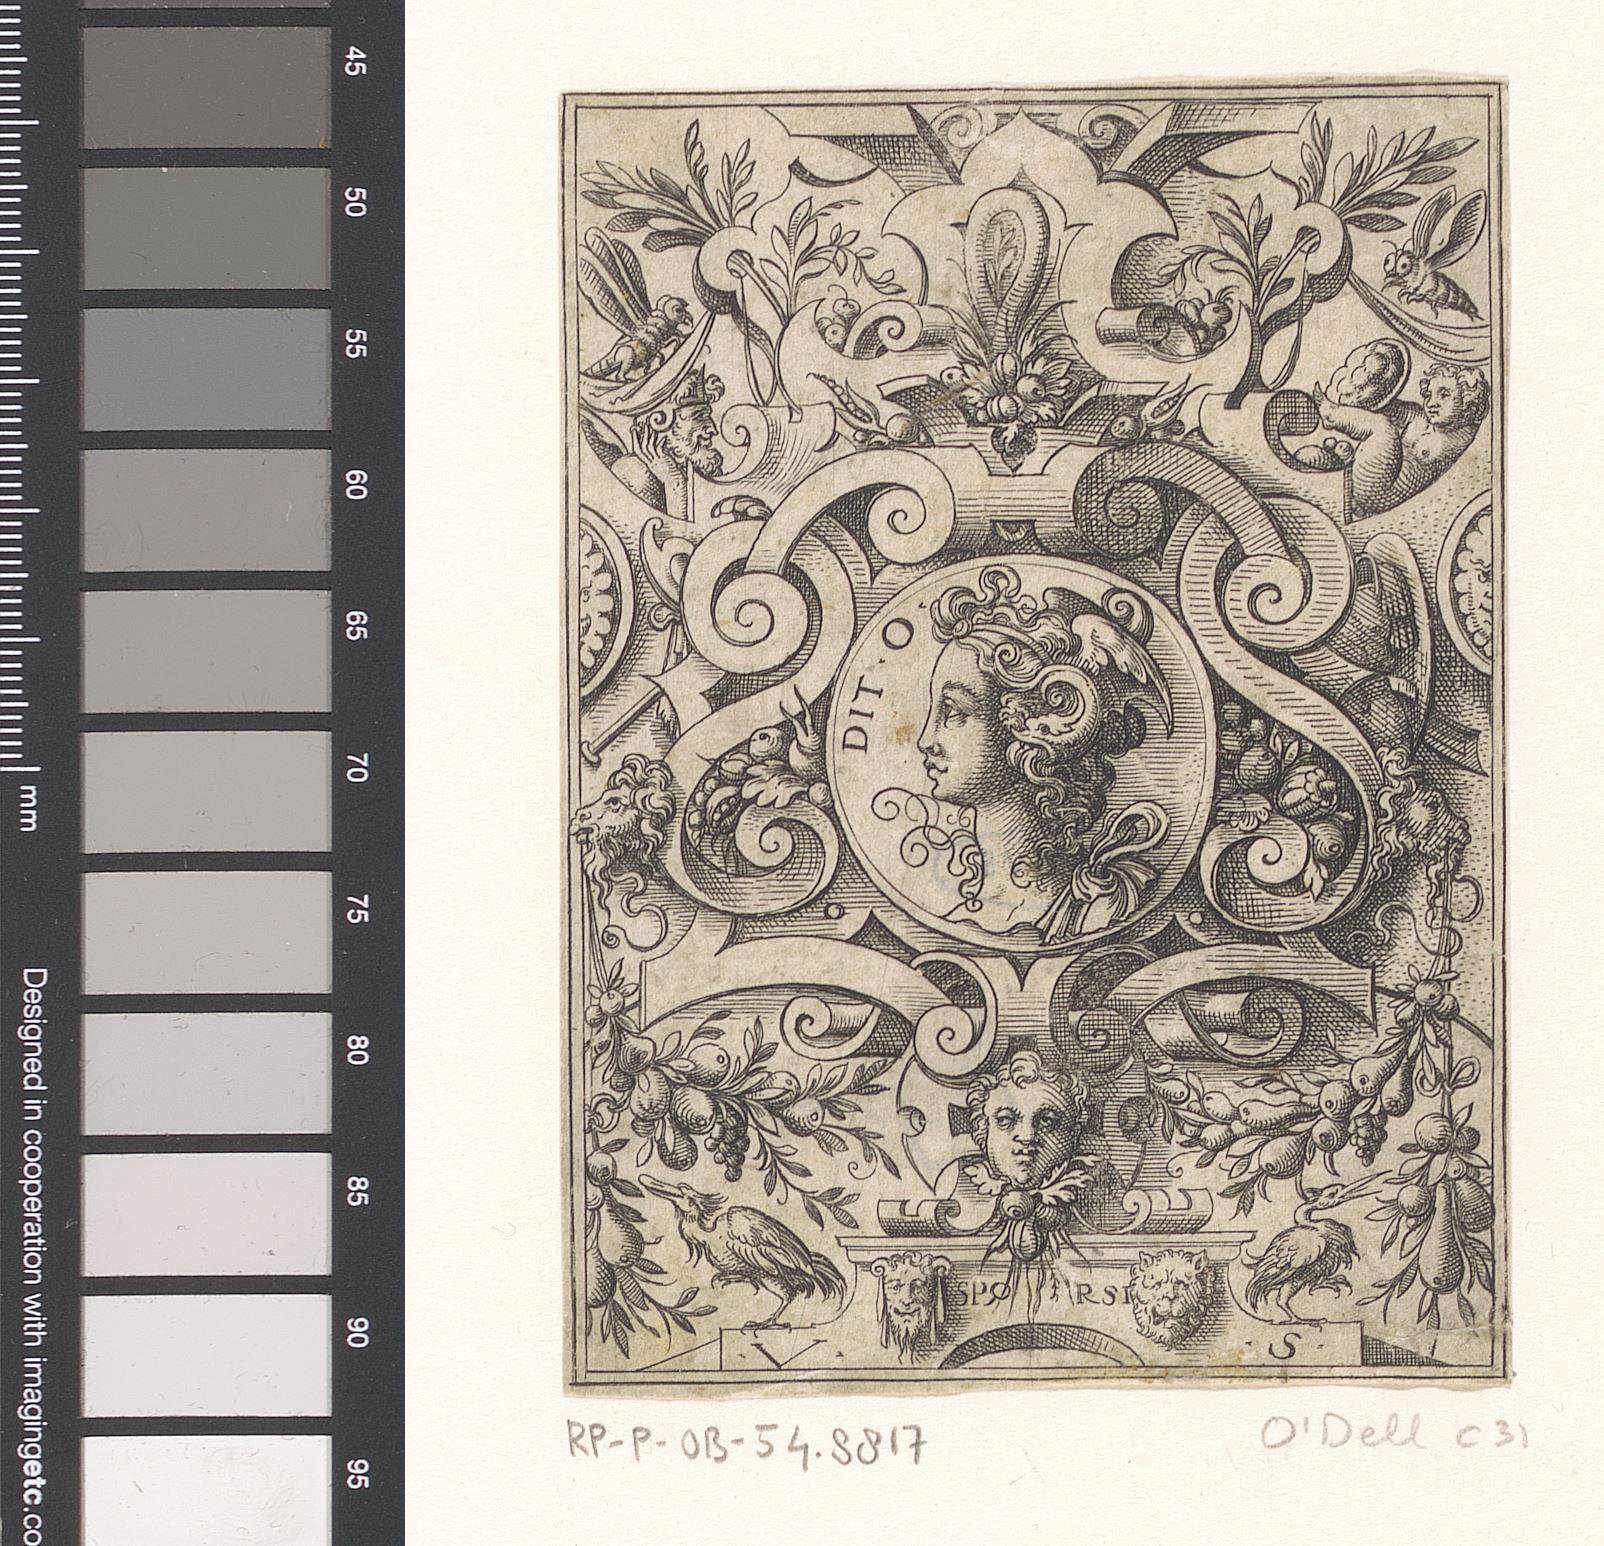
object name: ornament print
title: Medaillon met Dido in een rolwerk omlijsting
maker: virgilius solis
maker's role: draughtsman, print maker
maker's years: 1514-1562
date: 1524-1562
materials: paper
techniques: engraving, etching, intaglio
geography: nuremberg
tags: (story of) dido, scrollwork, strapwork ~ ornament, mask, mascaron ~ ornament, ornament derived from plant forms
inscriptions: number: ‘95’, collector's mark: Lugt 2228